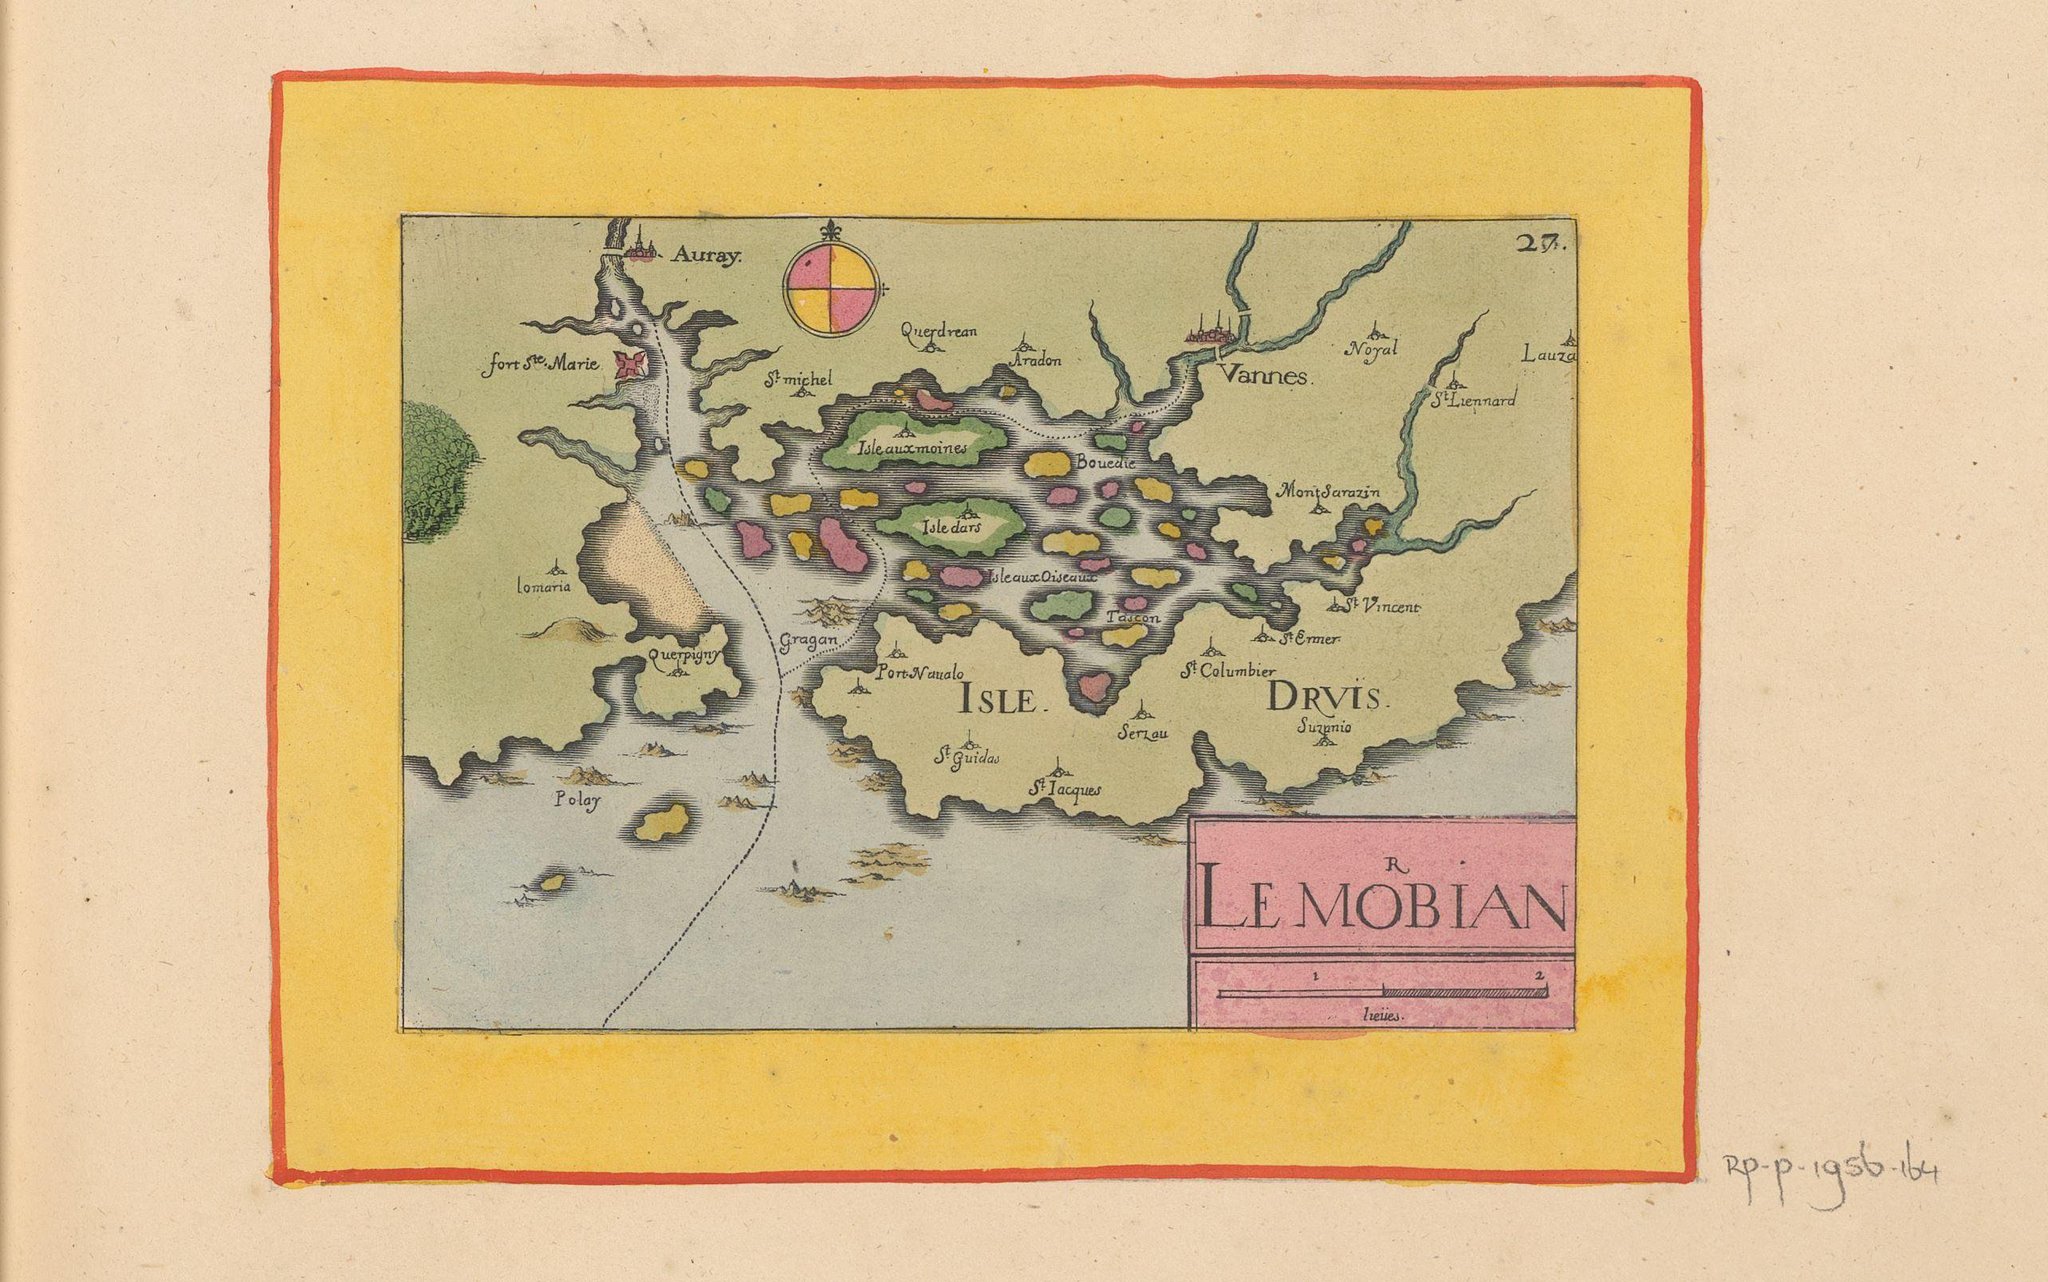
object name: print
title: Kaart van het departement Morbihan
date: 1638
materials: paper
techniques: engraving, hand coloring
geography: paris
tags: maps of separate countries or regions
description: Prent uit: Tassin, Christophe. Les plans et profils de toutes les principales villes et lieux considérables de France (...). Parijs: Michel van Lochom, 1638, prent nummer 27 in het deel 'Bretaigne'.